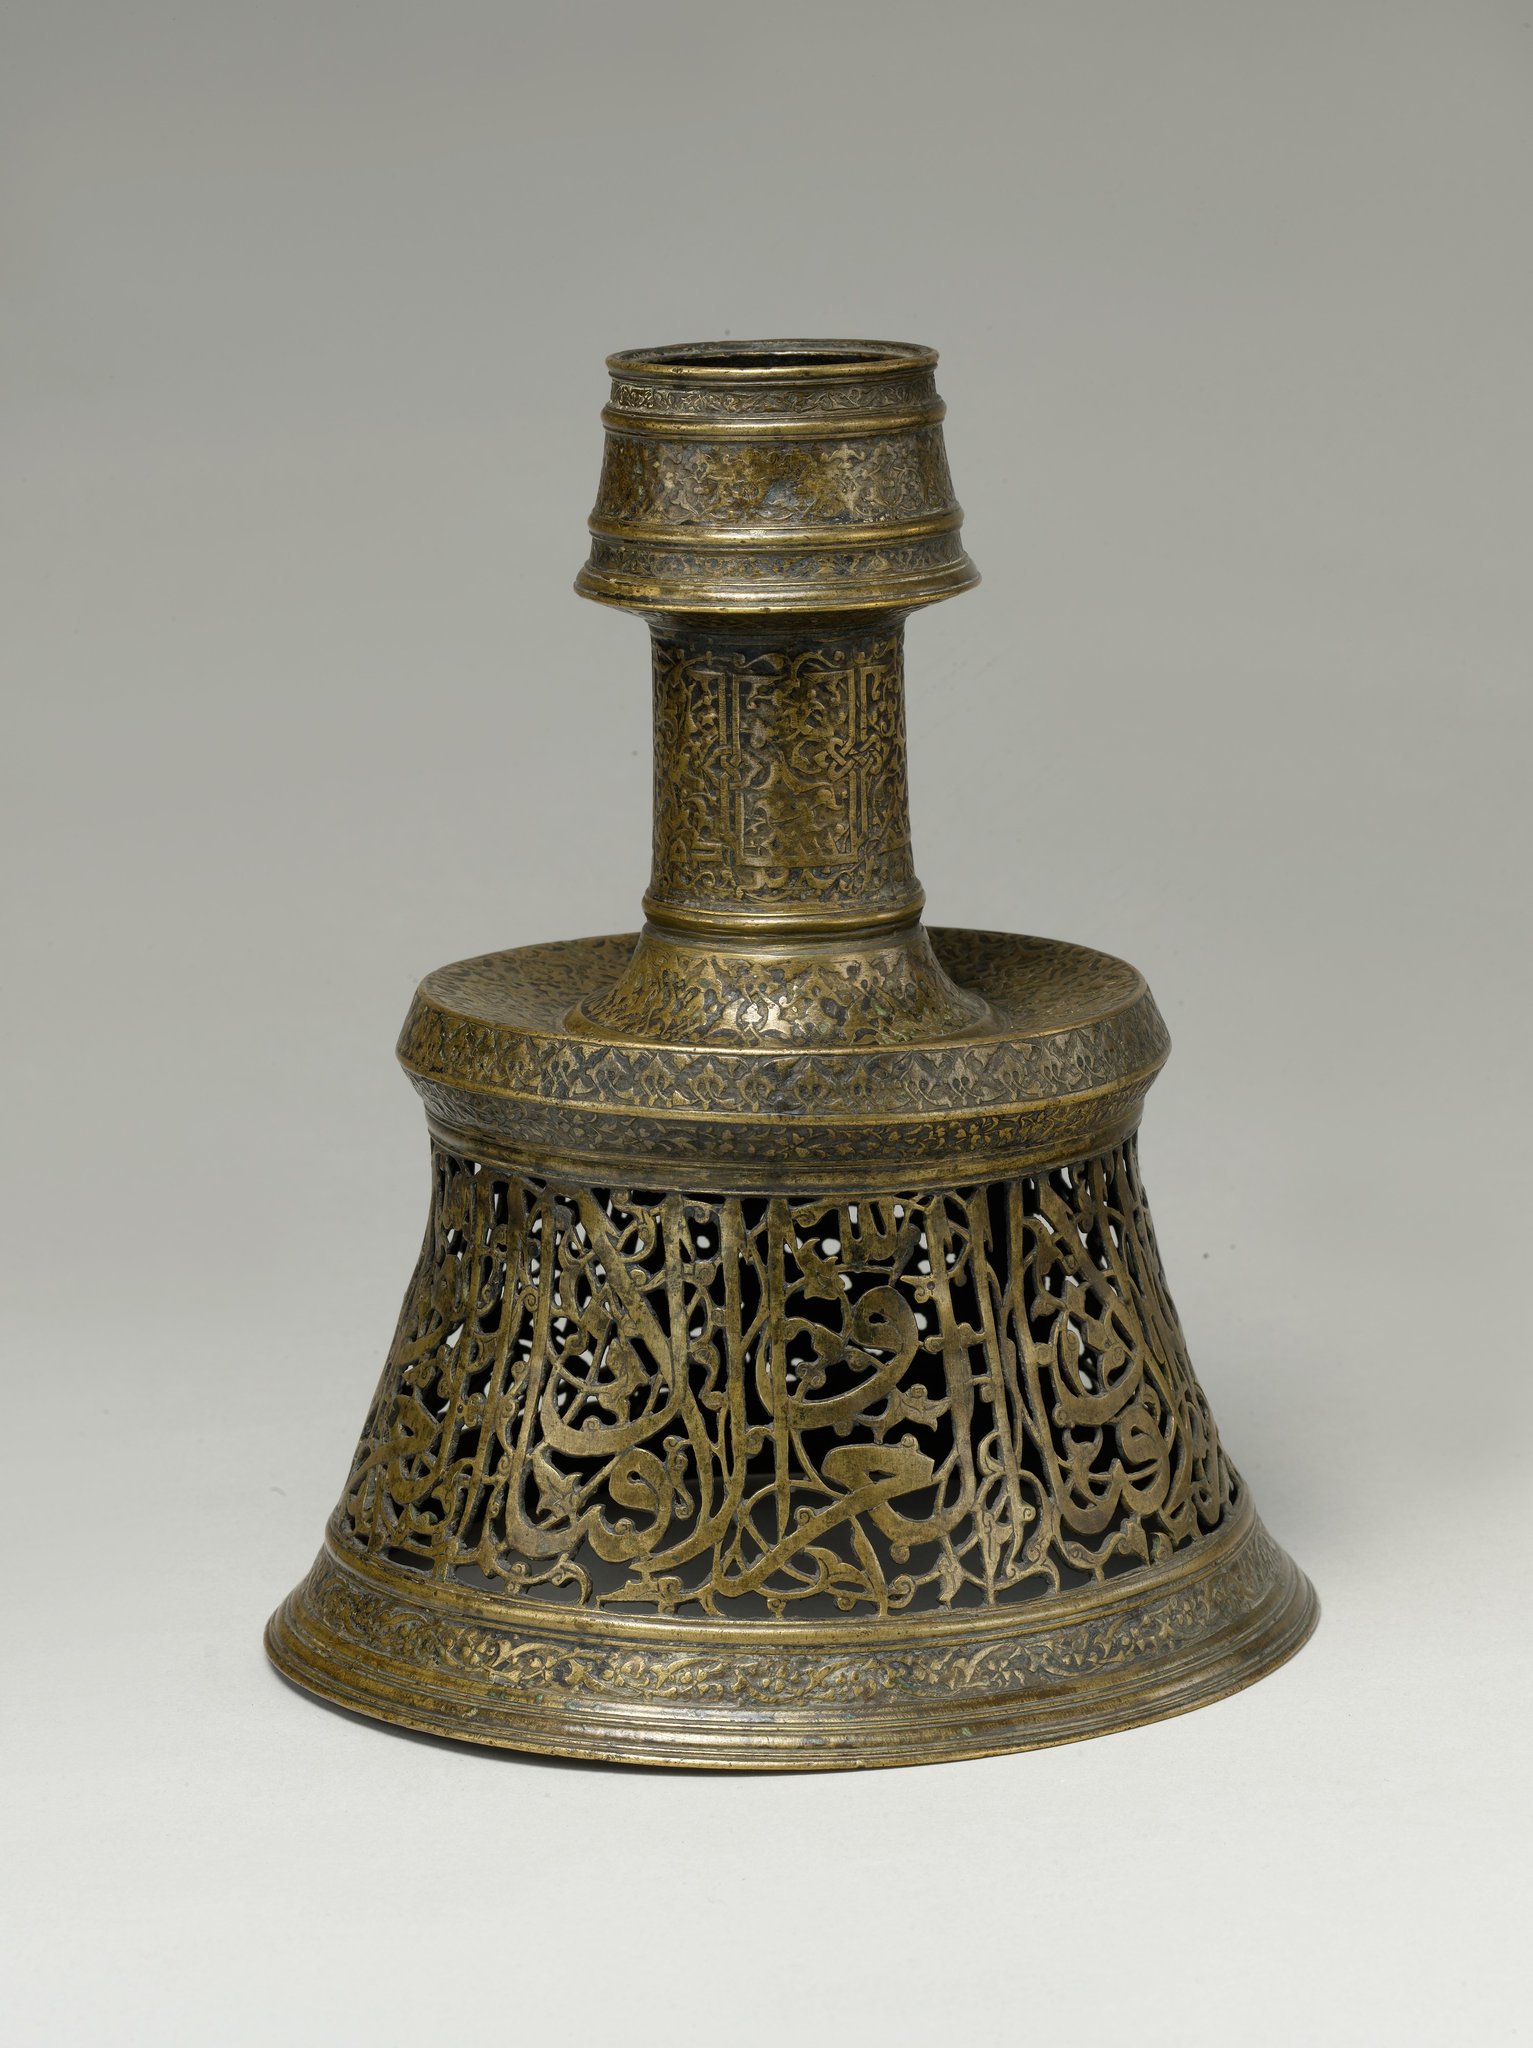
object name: candlestick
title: Candlestick inscribed with Wishes for Good Fortune, Peace, and Happiness to its Owner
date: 1500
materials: brass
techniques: casting, engraving, inlay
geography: iran